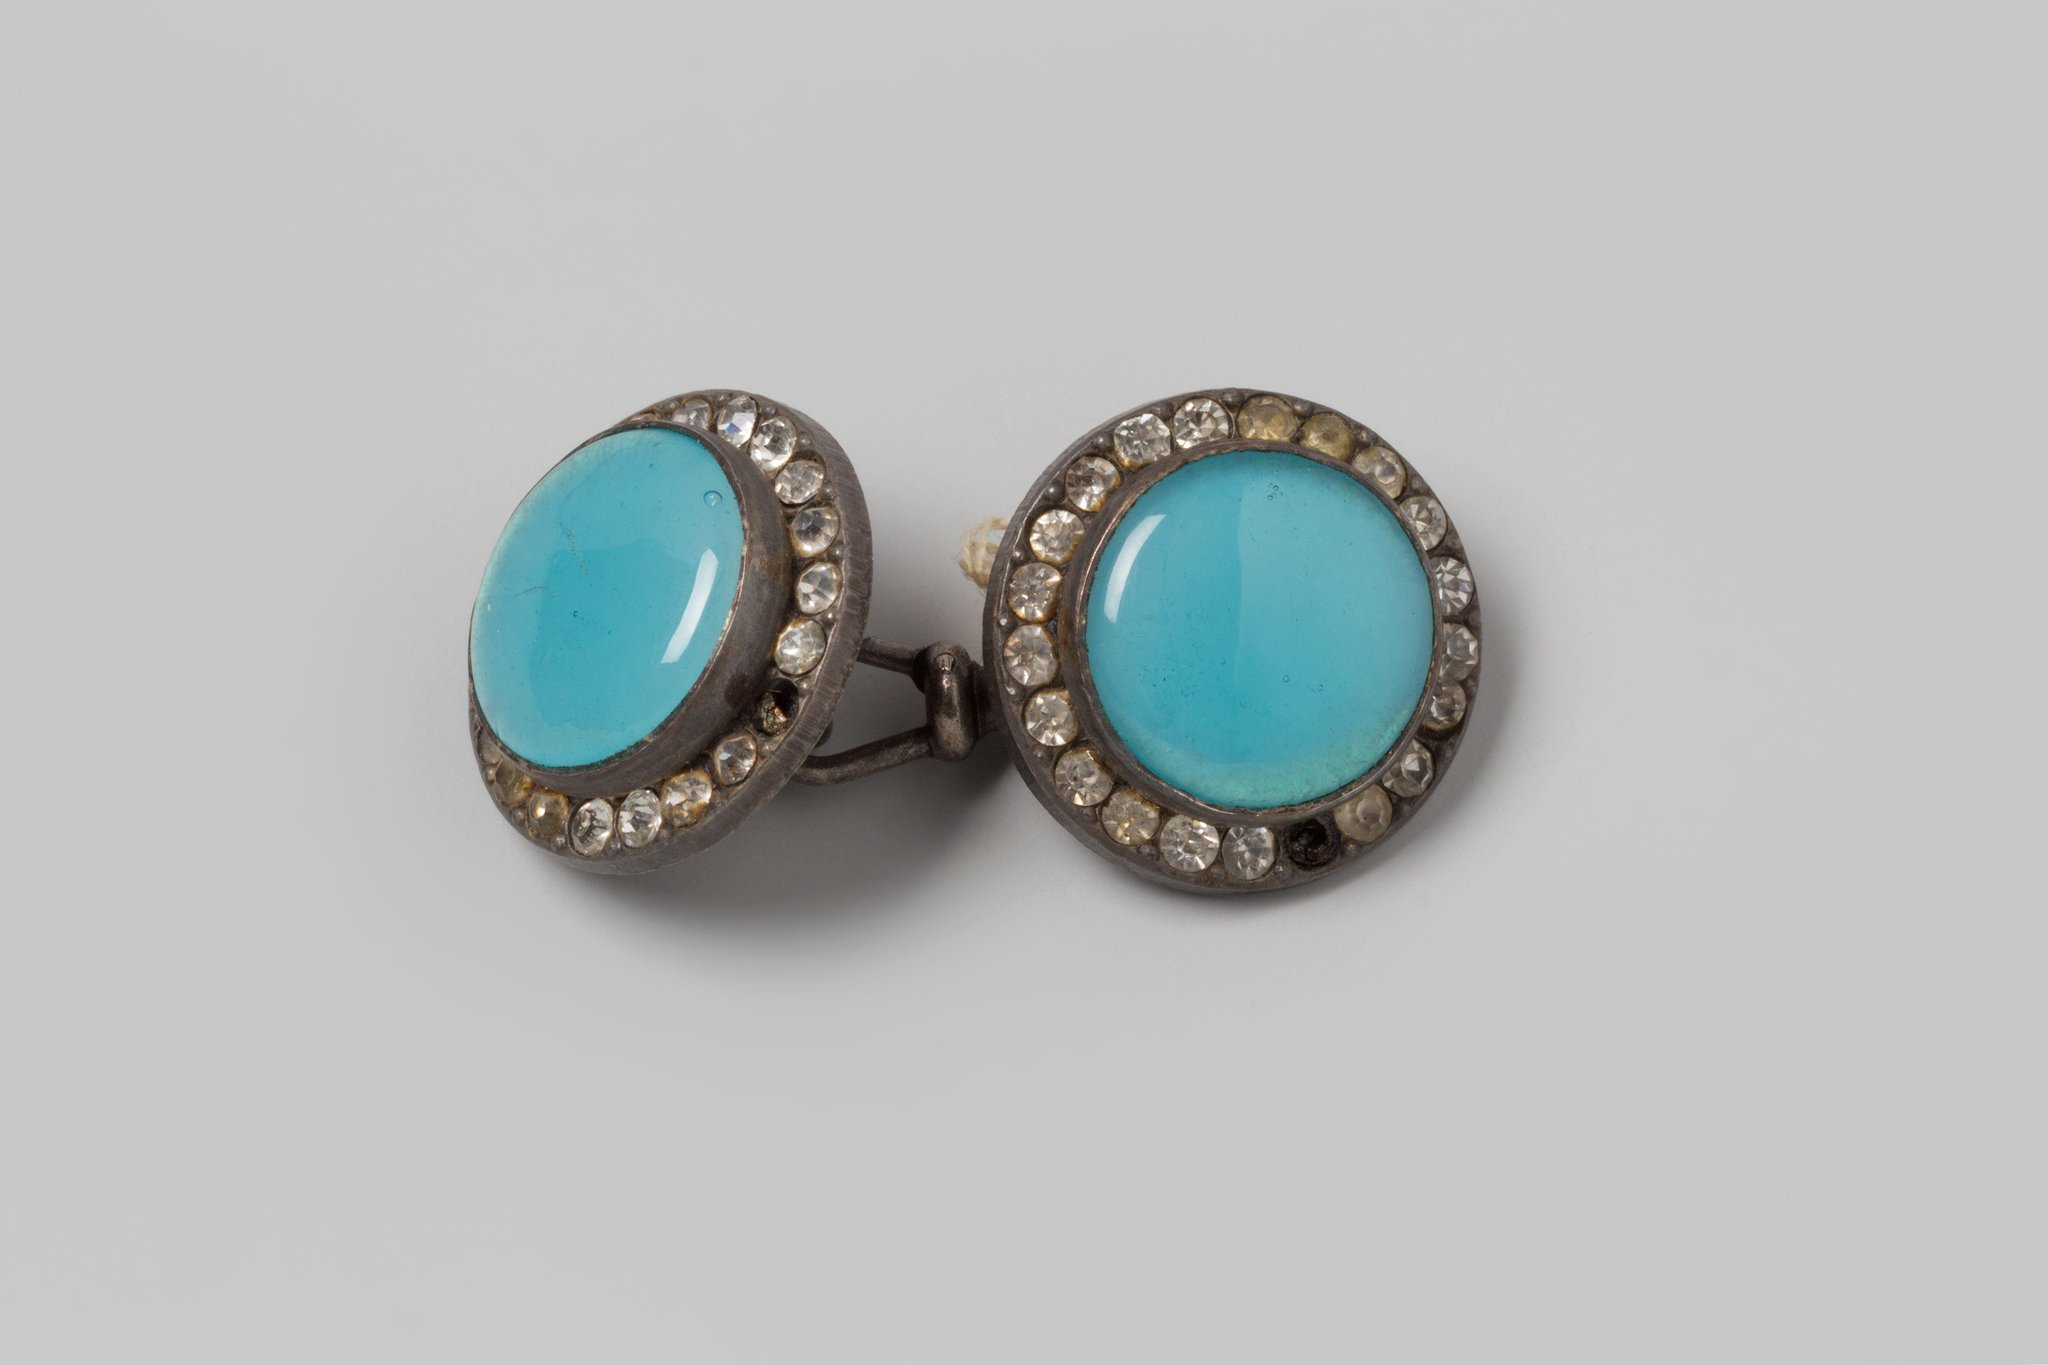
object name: cuff link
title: Manchetknoop bestaande uit een lichtblauwe bolronde steen met een omlijsting van strasstenen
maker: Anonymous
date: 1900-1950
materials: metal, paste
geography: netherlands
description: Ronde manchetknoop bestaande uit een lichtblauwe bolronde steen met een omlijsting van strasstenen. Aan de achterzijde een oogje.